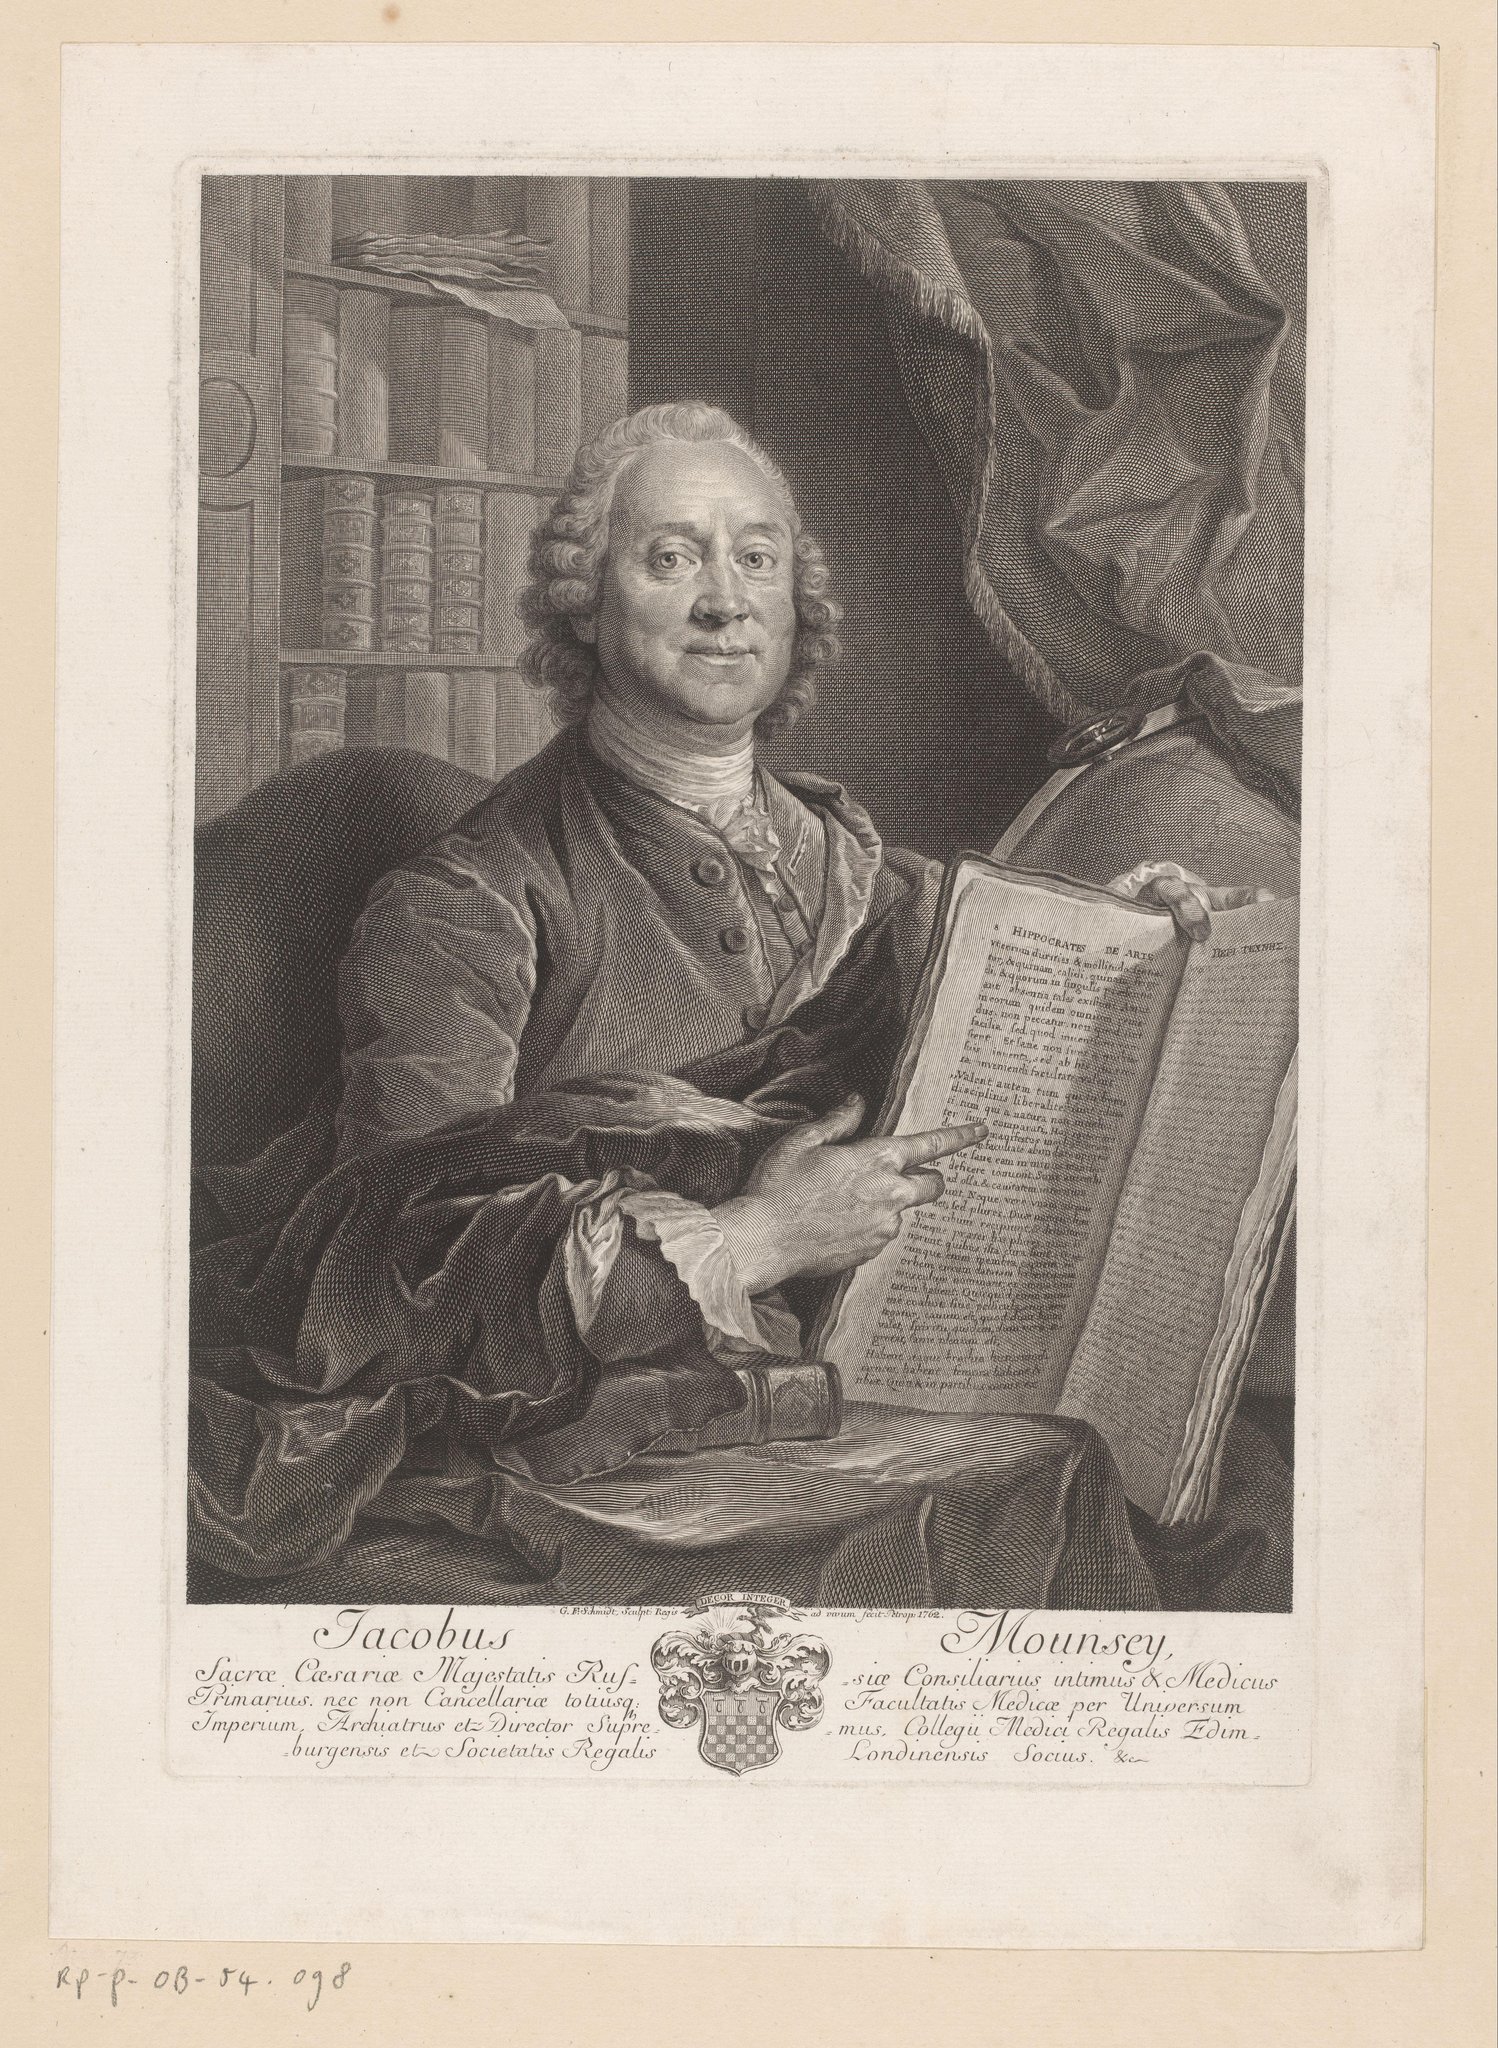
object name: print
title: Portret van James Mounsey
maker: georg friedrich schmidt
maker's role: draughtsman, print maker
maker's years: 1712-1775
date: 1762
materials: paper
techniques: engraving, etching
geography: sint-petersburg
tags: historical persons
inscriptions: collector's mark: Lugt 240